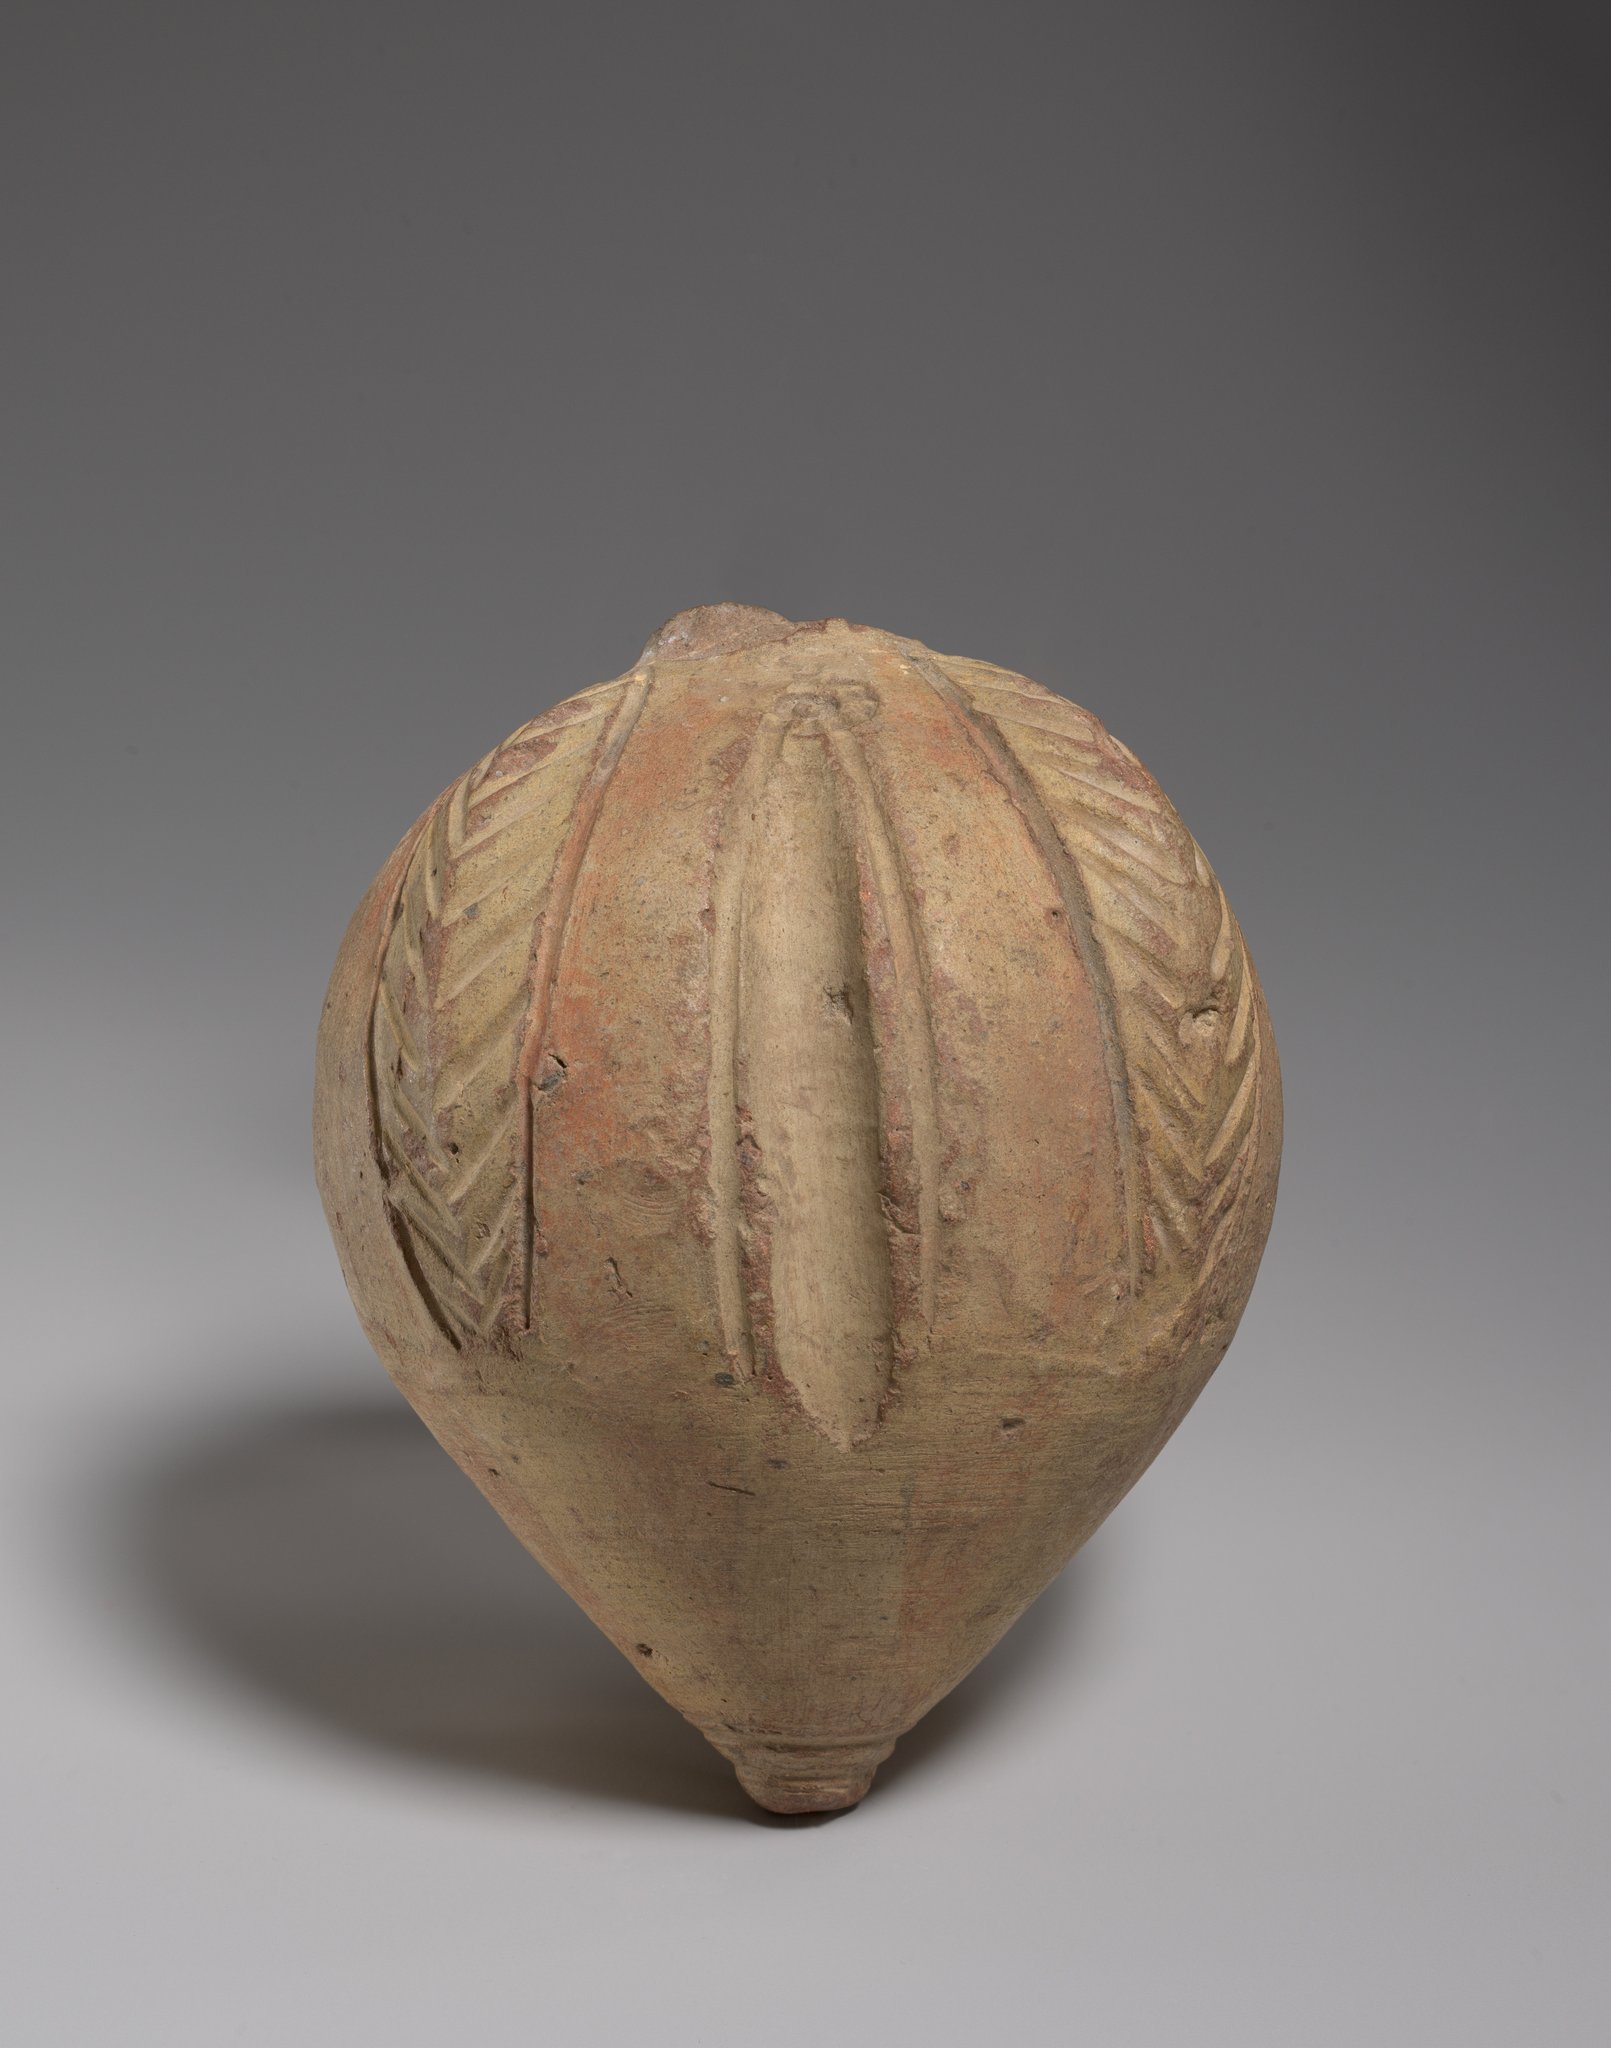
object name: vessel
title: Spheroconical Vessel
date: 801-1000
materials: earthenware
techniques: incising, polychrome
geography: iran